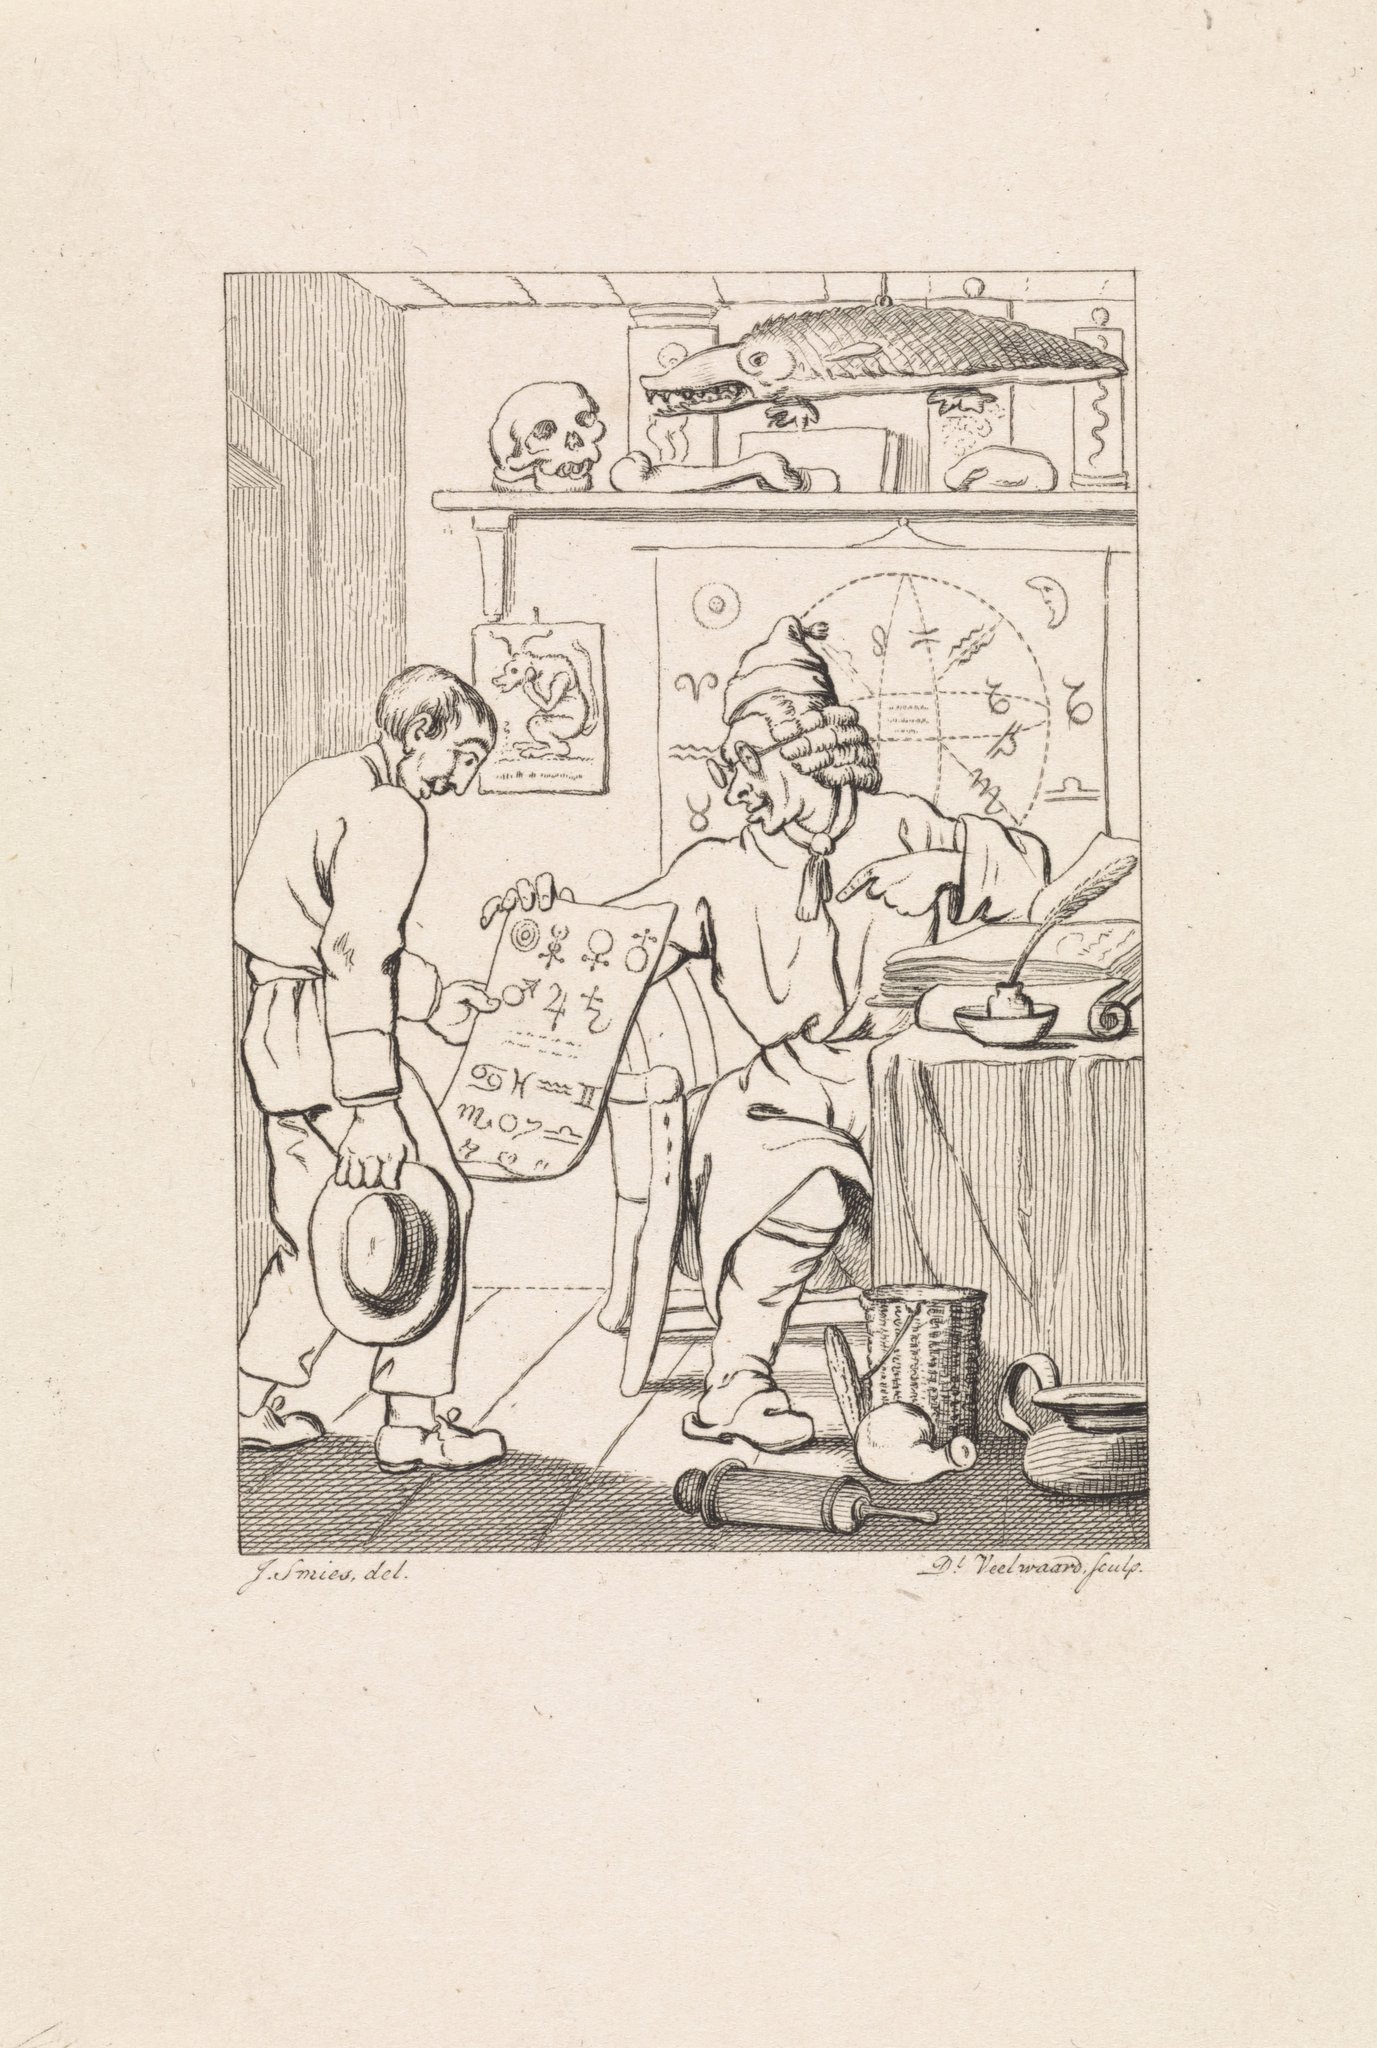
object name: print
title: Man toont een blad met de symbolen van de tekenen van de dierenriem aan een andere figuur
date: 1833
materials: paper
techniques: engraving, etching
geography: amsterdam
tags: scholar in his study, caricatures (human types), astrological signs and symbols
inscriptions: collector's mark: Lugt 2228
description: In een interieur toont een man zittend aan een tafel een blad met de symbolen van de tekenen van de dierenriem aan een andere figuur, die naast hem staat met zijn hoed in de hand.